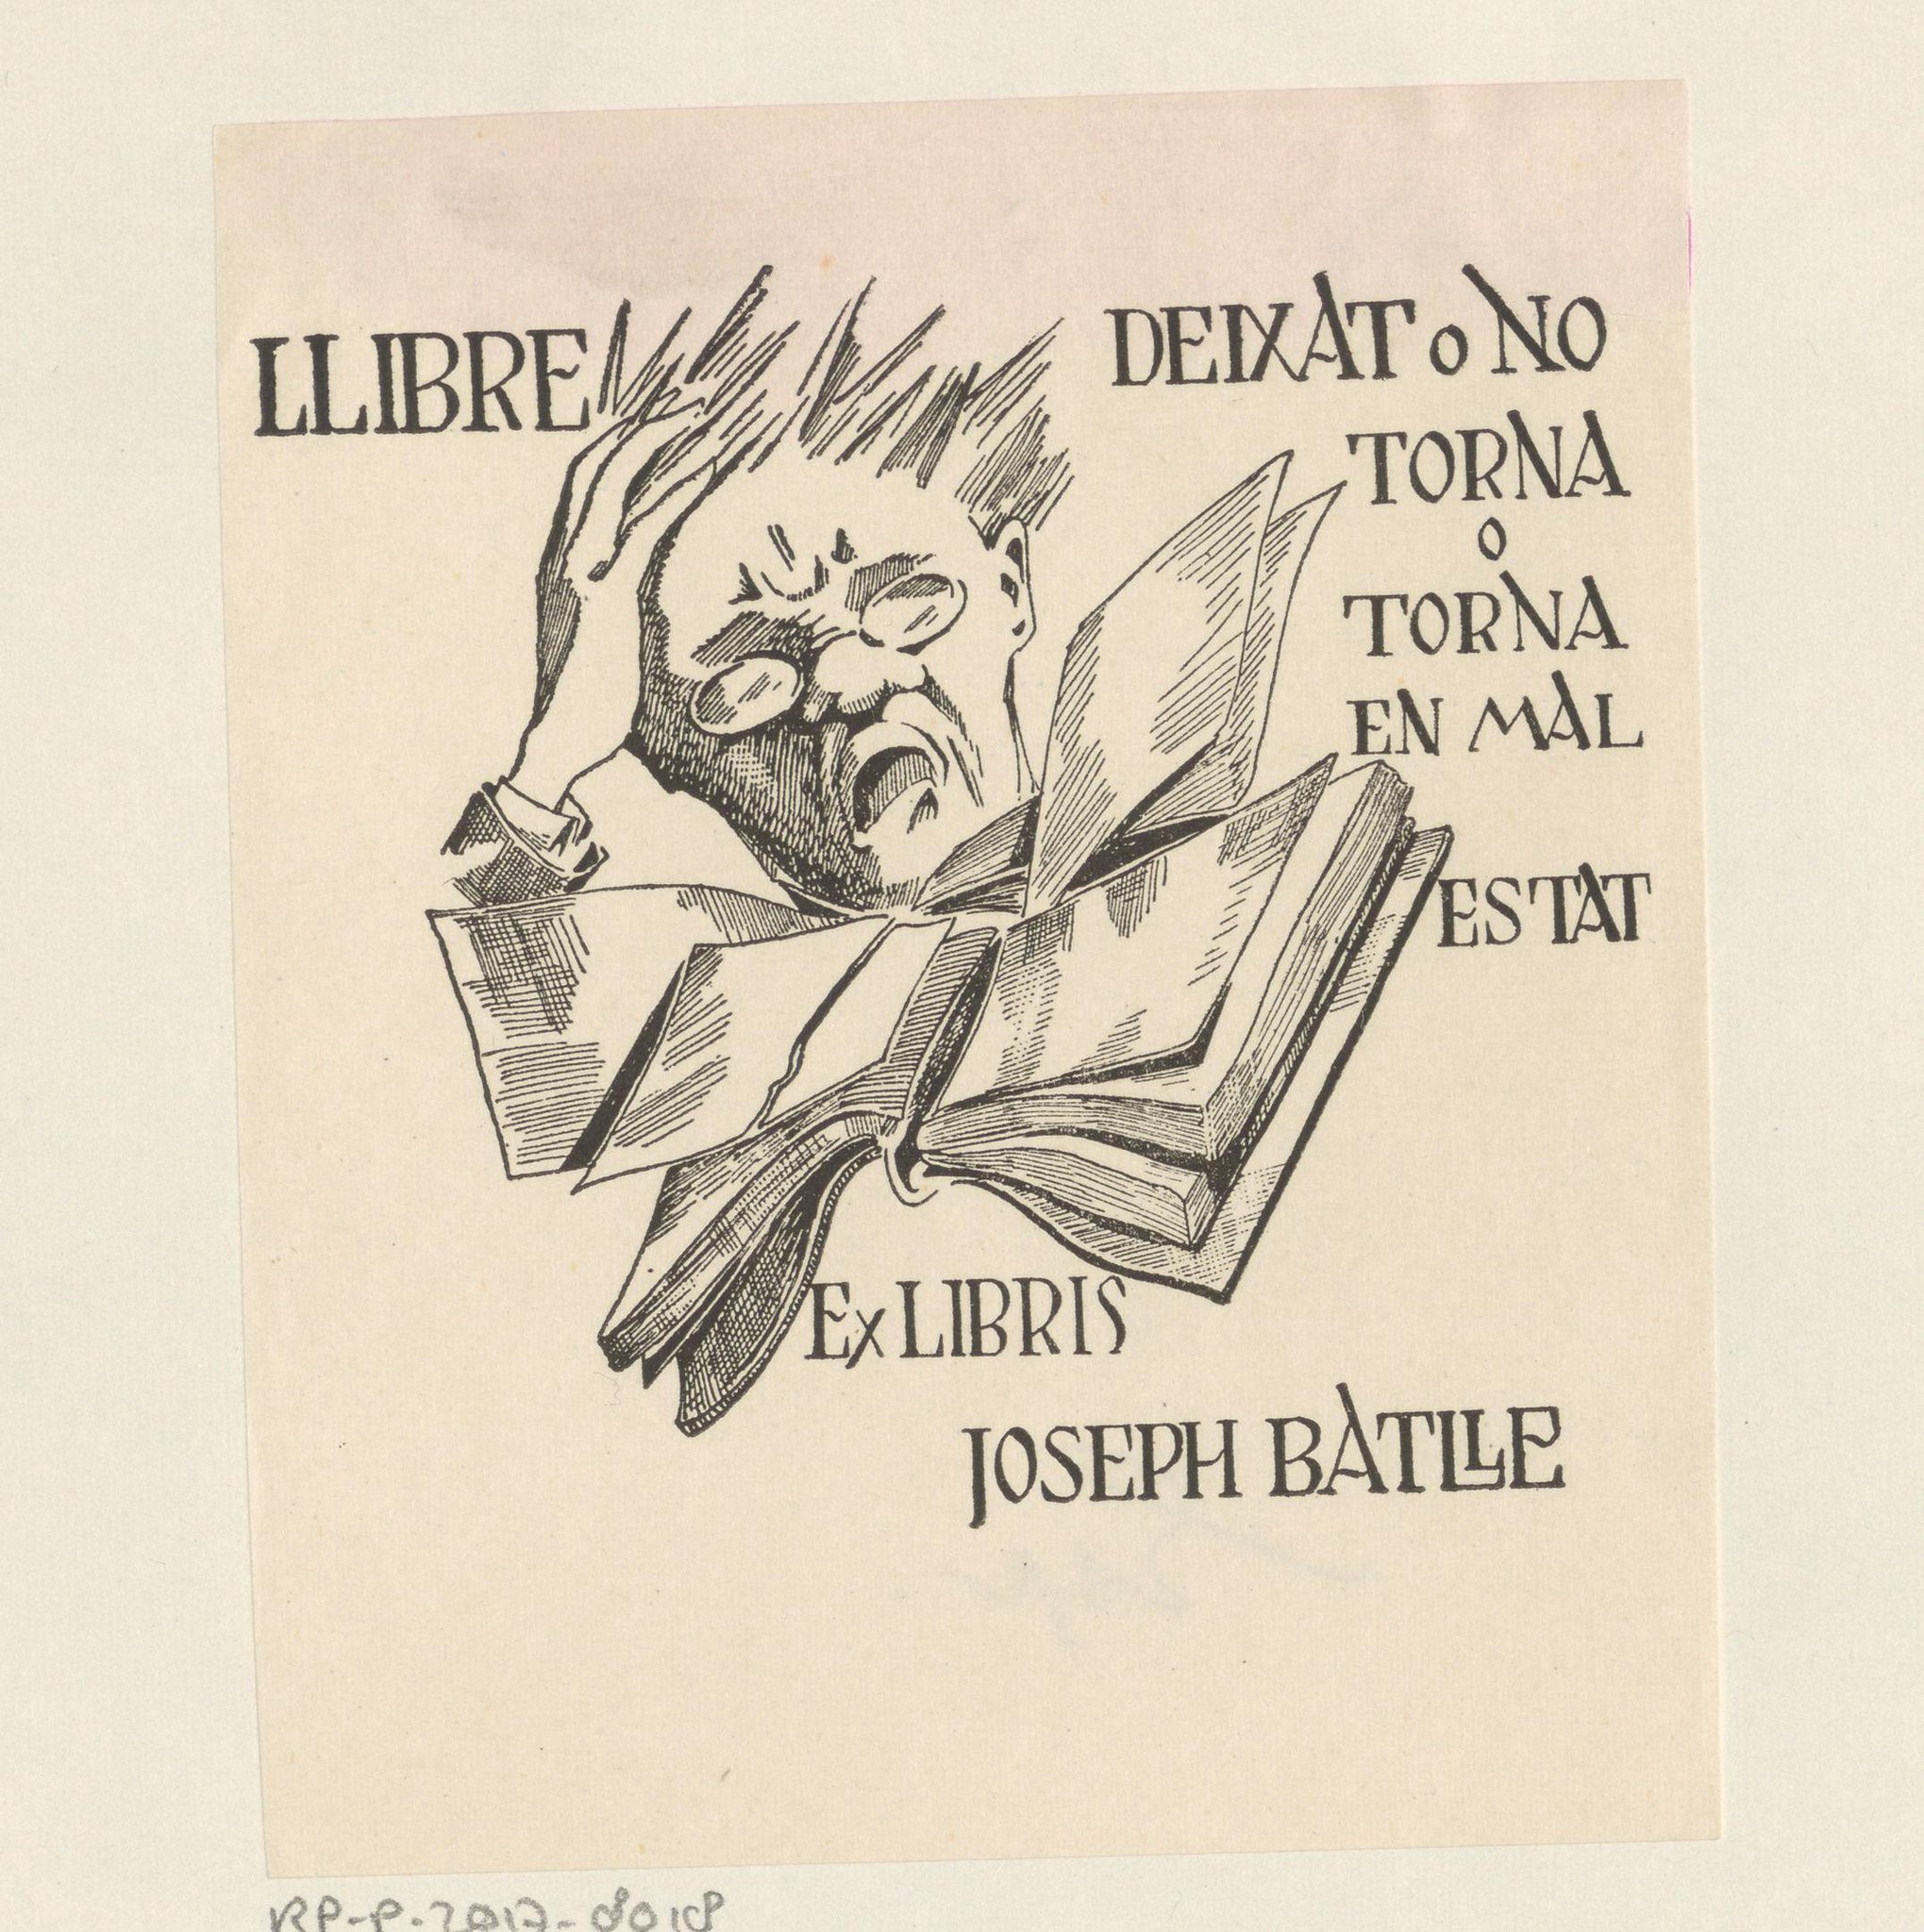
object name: bookplate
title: Ex libris van Joseph Batlle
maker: Anonymous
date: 1900-1999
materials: paper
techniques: printing block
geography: spain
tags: eyeglasses, spectacles, head (human), book